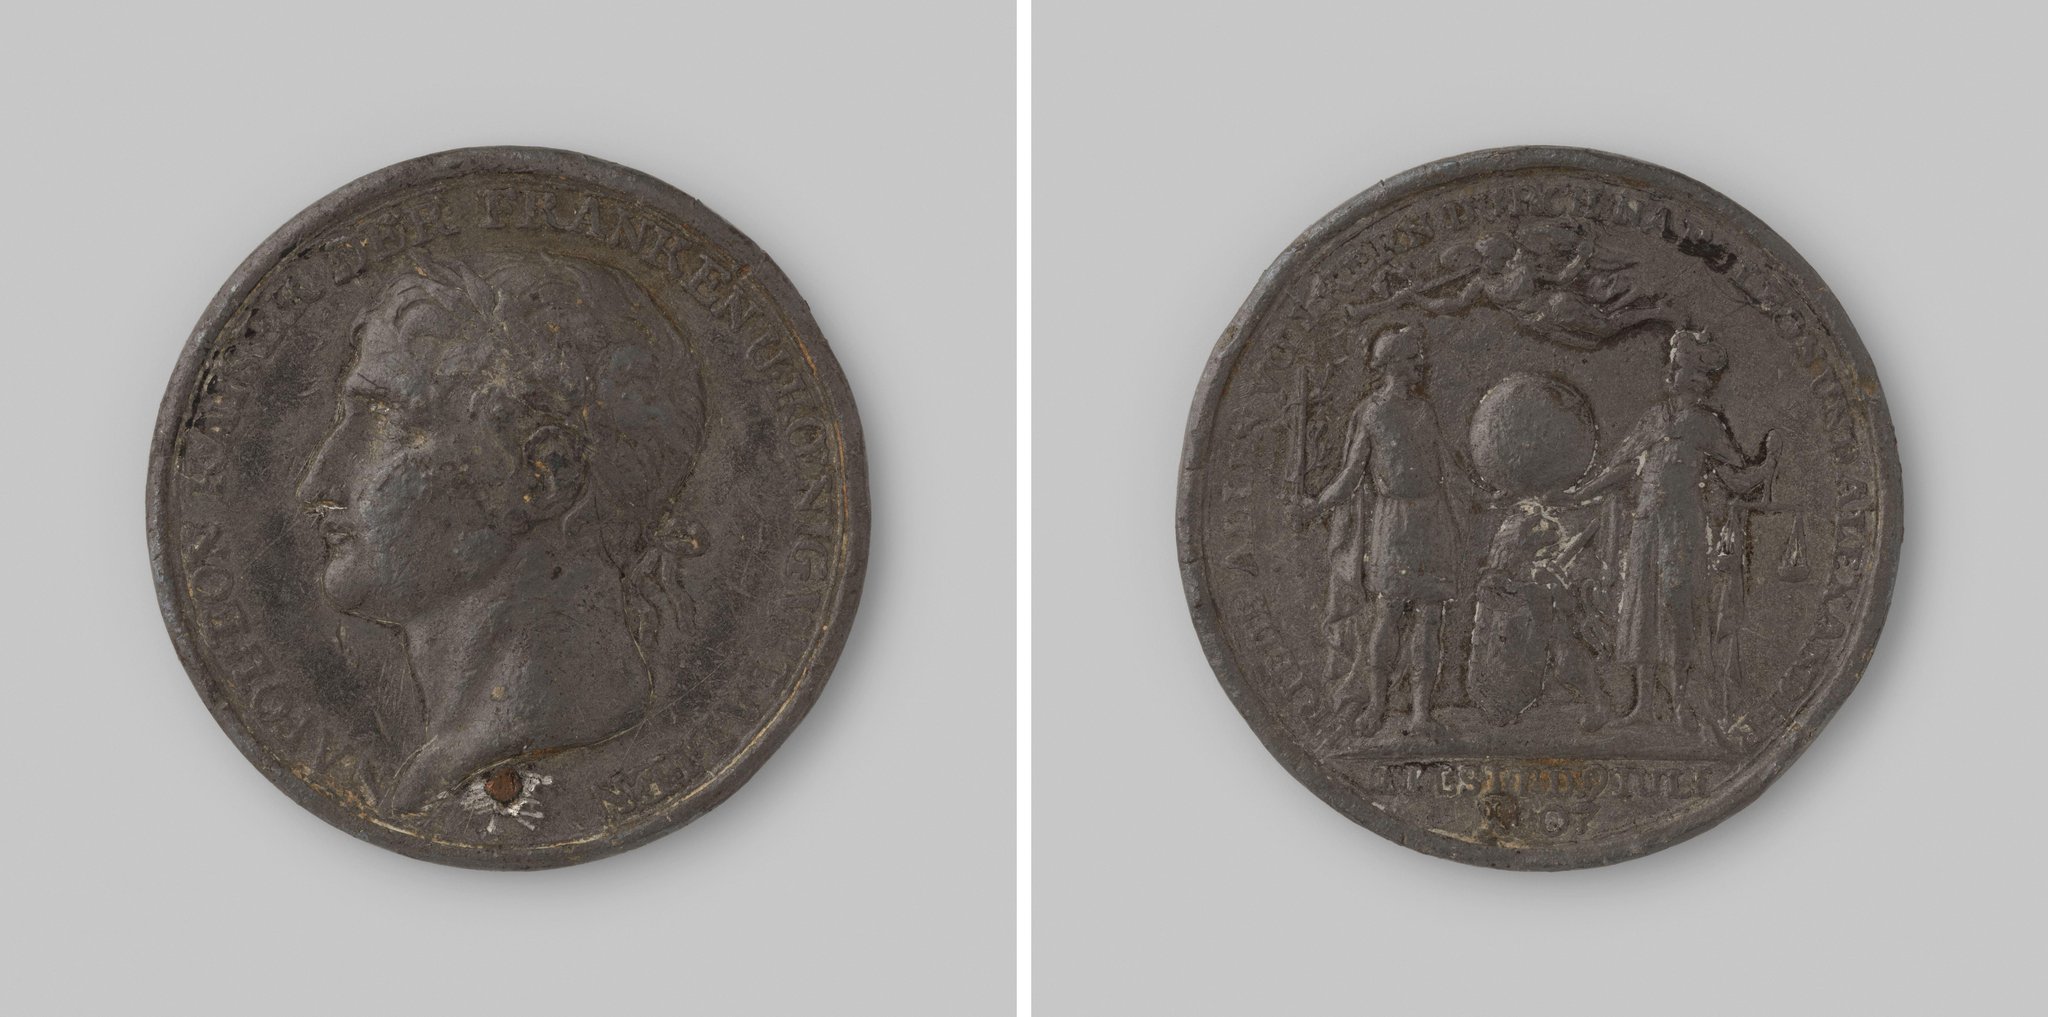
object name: history medal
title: Vrede van Tilsit, ter ere van Napoleon I Bonaparte, keizer der Fransen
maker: Anonymous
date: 1807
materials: lead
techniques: striking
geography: germany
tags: napoleon i (emperor of the french)